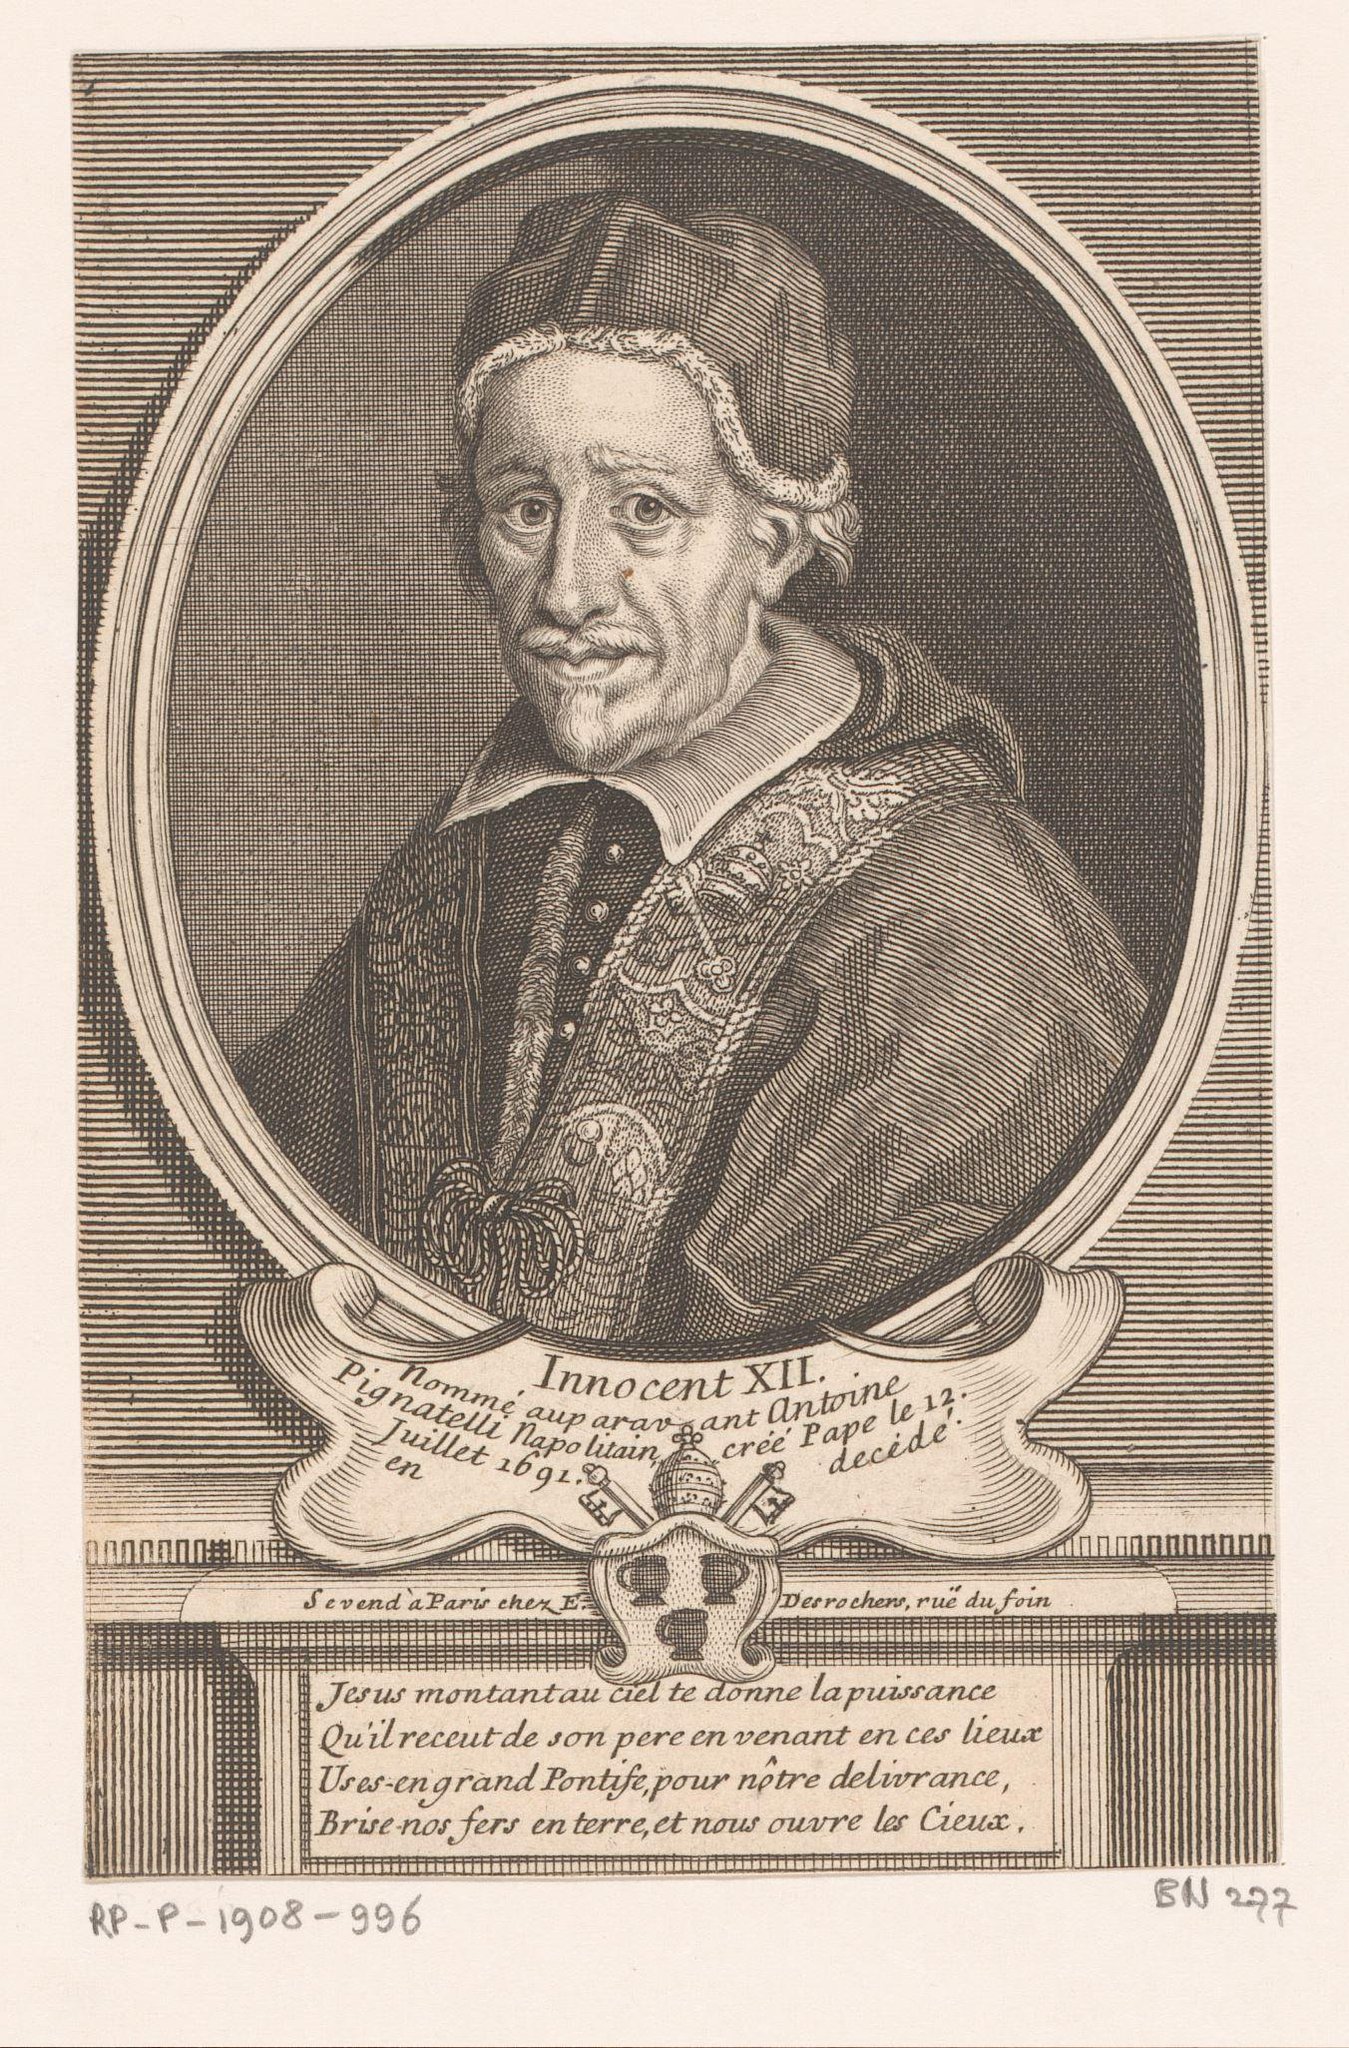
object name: print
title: Recueil de portraits (...)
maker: étienne desrochers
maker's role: print maker, publisher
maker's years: 1668-1741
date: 1726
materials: paper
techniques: engraving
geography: paris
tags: clergyman, innocentius xii, historical persons, pope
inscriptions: collector's mark: Lugt 2228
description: Behoort waarschijnlijk tot een serie portretten, grotendeels door Etienne Desrochers, getiteld: 'Recueil de portraits de personnes qui se sont distinguées tant dans les Armes que dans Belles-Lettres et les Arts, comme aussi la famille royale de France et autres cours étrangères'. De serie werd initieel uitgegeven door Desrochers en aangekondigd in 'Mercure' in mei 1726, p. 985. Echter was Desrochers reeds enkele jaren eerder begonnen met het uitgeven van de serie. Na de dood van Desrochers werd de serie voortgezet door Gilles Edme Petit. Een latere staat werd uitgegeven door Jean François Daumont in Parijs.